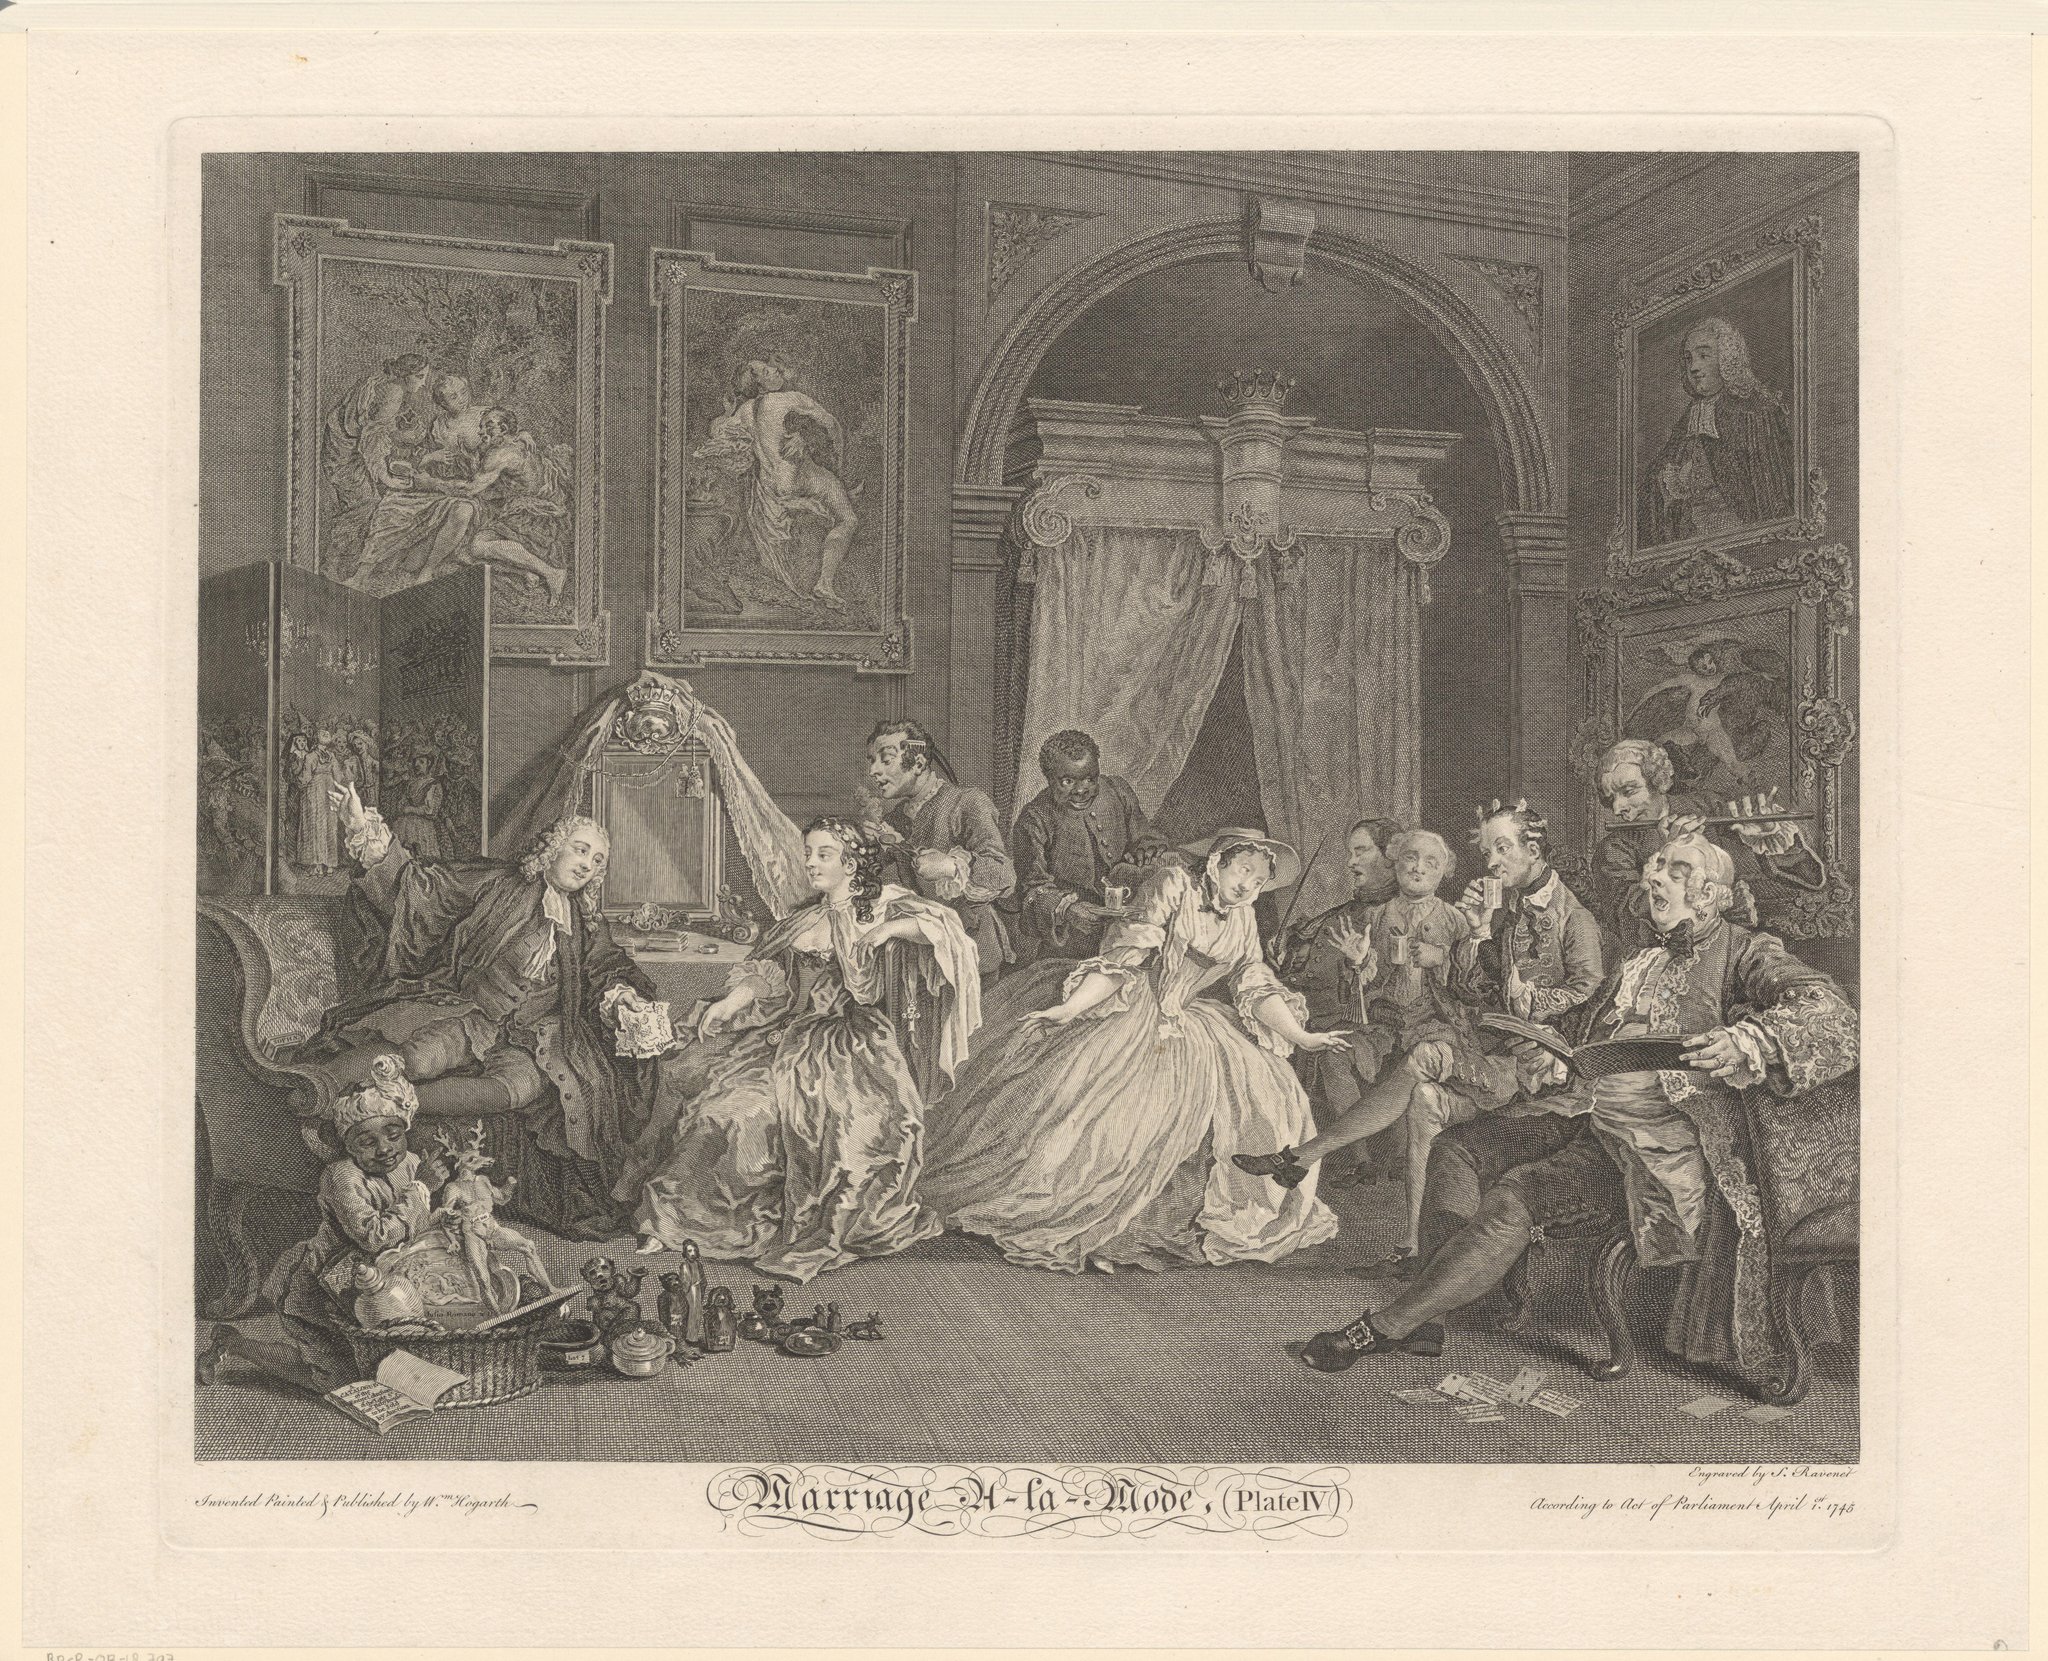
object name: print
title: Marriage A-la-Mode, Plate IV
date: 1704-1745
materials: paper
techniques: engraving, etching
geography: london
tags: partner deceived, transverse flute, vocal music, singing, hairdresser, picture, painting, satire on marriage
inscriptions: date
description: De vrouw, die door het overlijden van de vader van haar man gravin is geworden, zit bij een spiegel terwijl een kapper haar haar doet. Silvertongue zit naast haar. Rechts zit een zingende man. Een staande man achter hem speelt dwarsfluit. In het midden van de kamer zitten nog drie mannen en een vrouw, die een drankje aangeboden krijgt van een bediende. Aan de wanden hangen verschillende erotische schilderijen. Links vooraan zit een jongen bij een mand met spullen die aangeboden worden voor een veiling. Hij wijst naar de hoorns van een sculptuur van Actaeon, symbool voor de man van een overspelige vrouw.